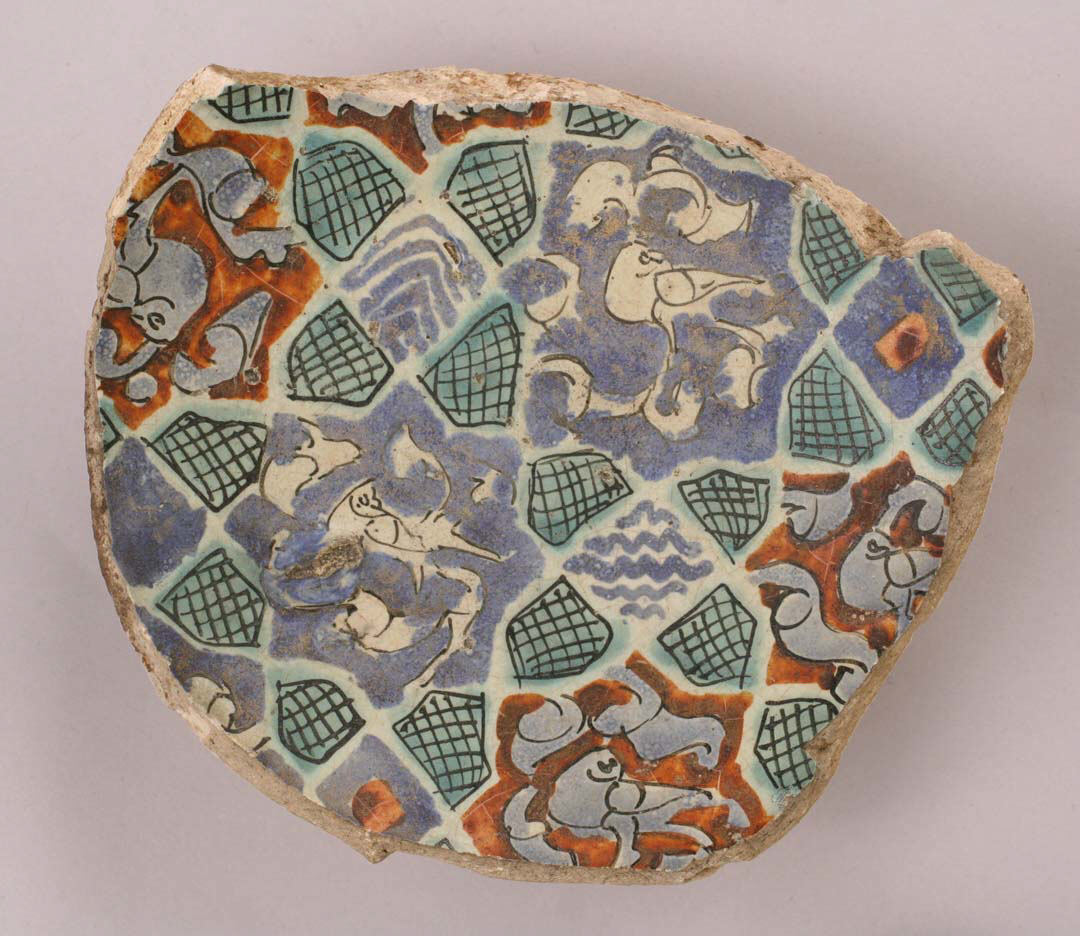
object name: fragment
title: Fragment of a Bowl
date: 1101-1300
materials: stonepaste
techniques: overglaze, painting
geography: iran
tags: birds